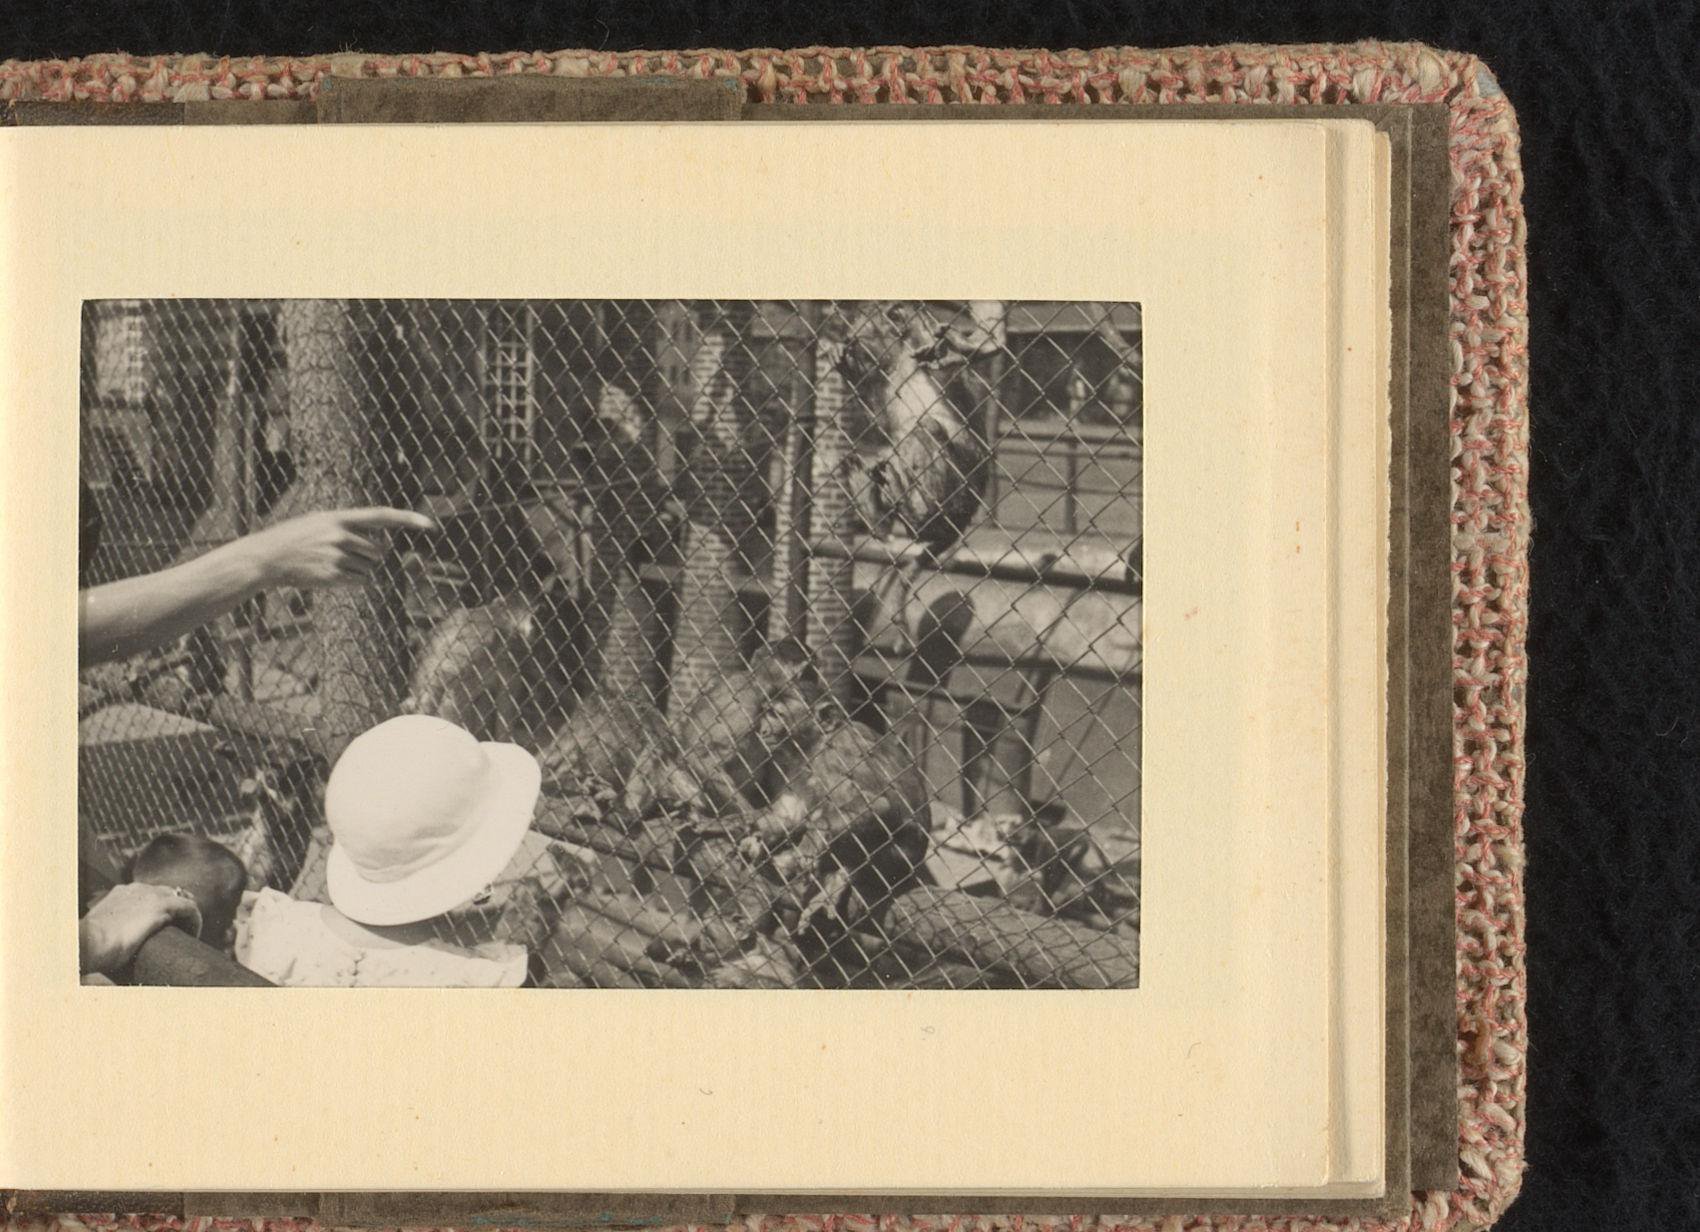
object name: album leaf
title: Isabel Wachenheimer voor het apenverblijf in de dierentuin, juni-augustus 1933, Hamburg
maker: else wachenheimer-moos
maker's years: 1895-1944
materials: paper, photographic support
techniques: gelatin silver print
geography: hamburg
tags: leiden, isabel wachenheimer-elon, the family travelling, on holiday, monkeys, apes, zoo (as place of recreation)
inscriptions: date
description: Albumblad bevat een foto van Isabel Wachenheimer. Onderdeel van het fotoalbum Hamburg zomer 1933.